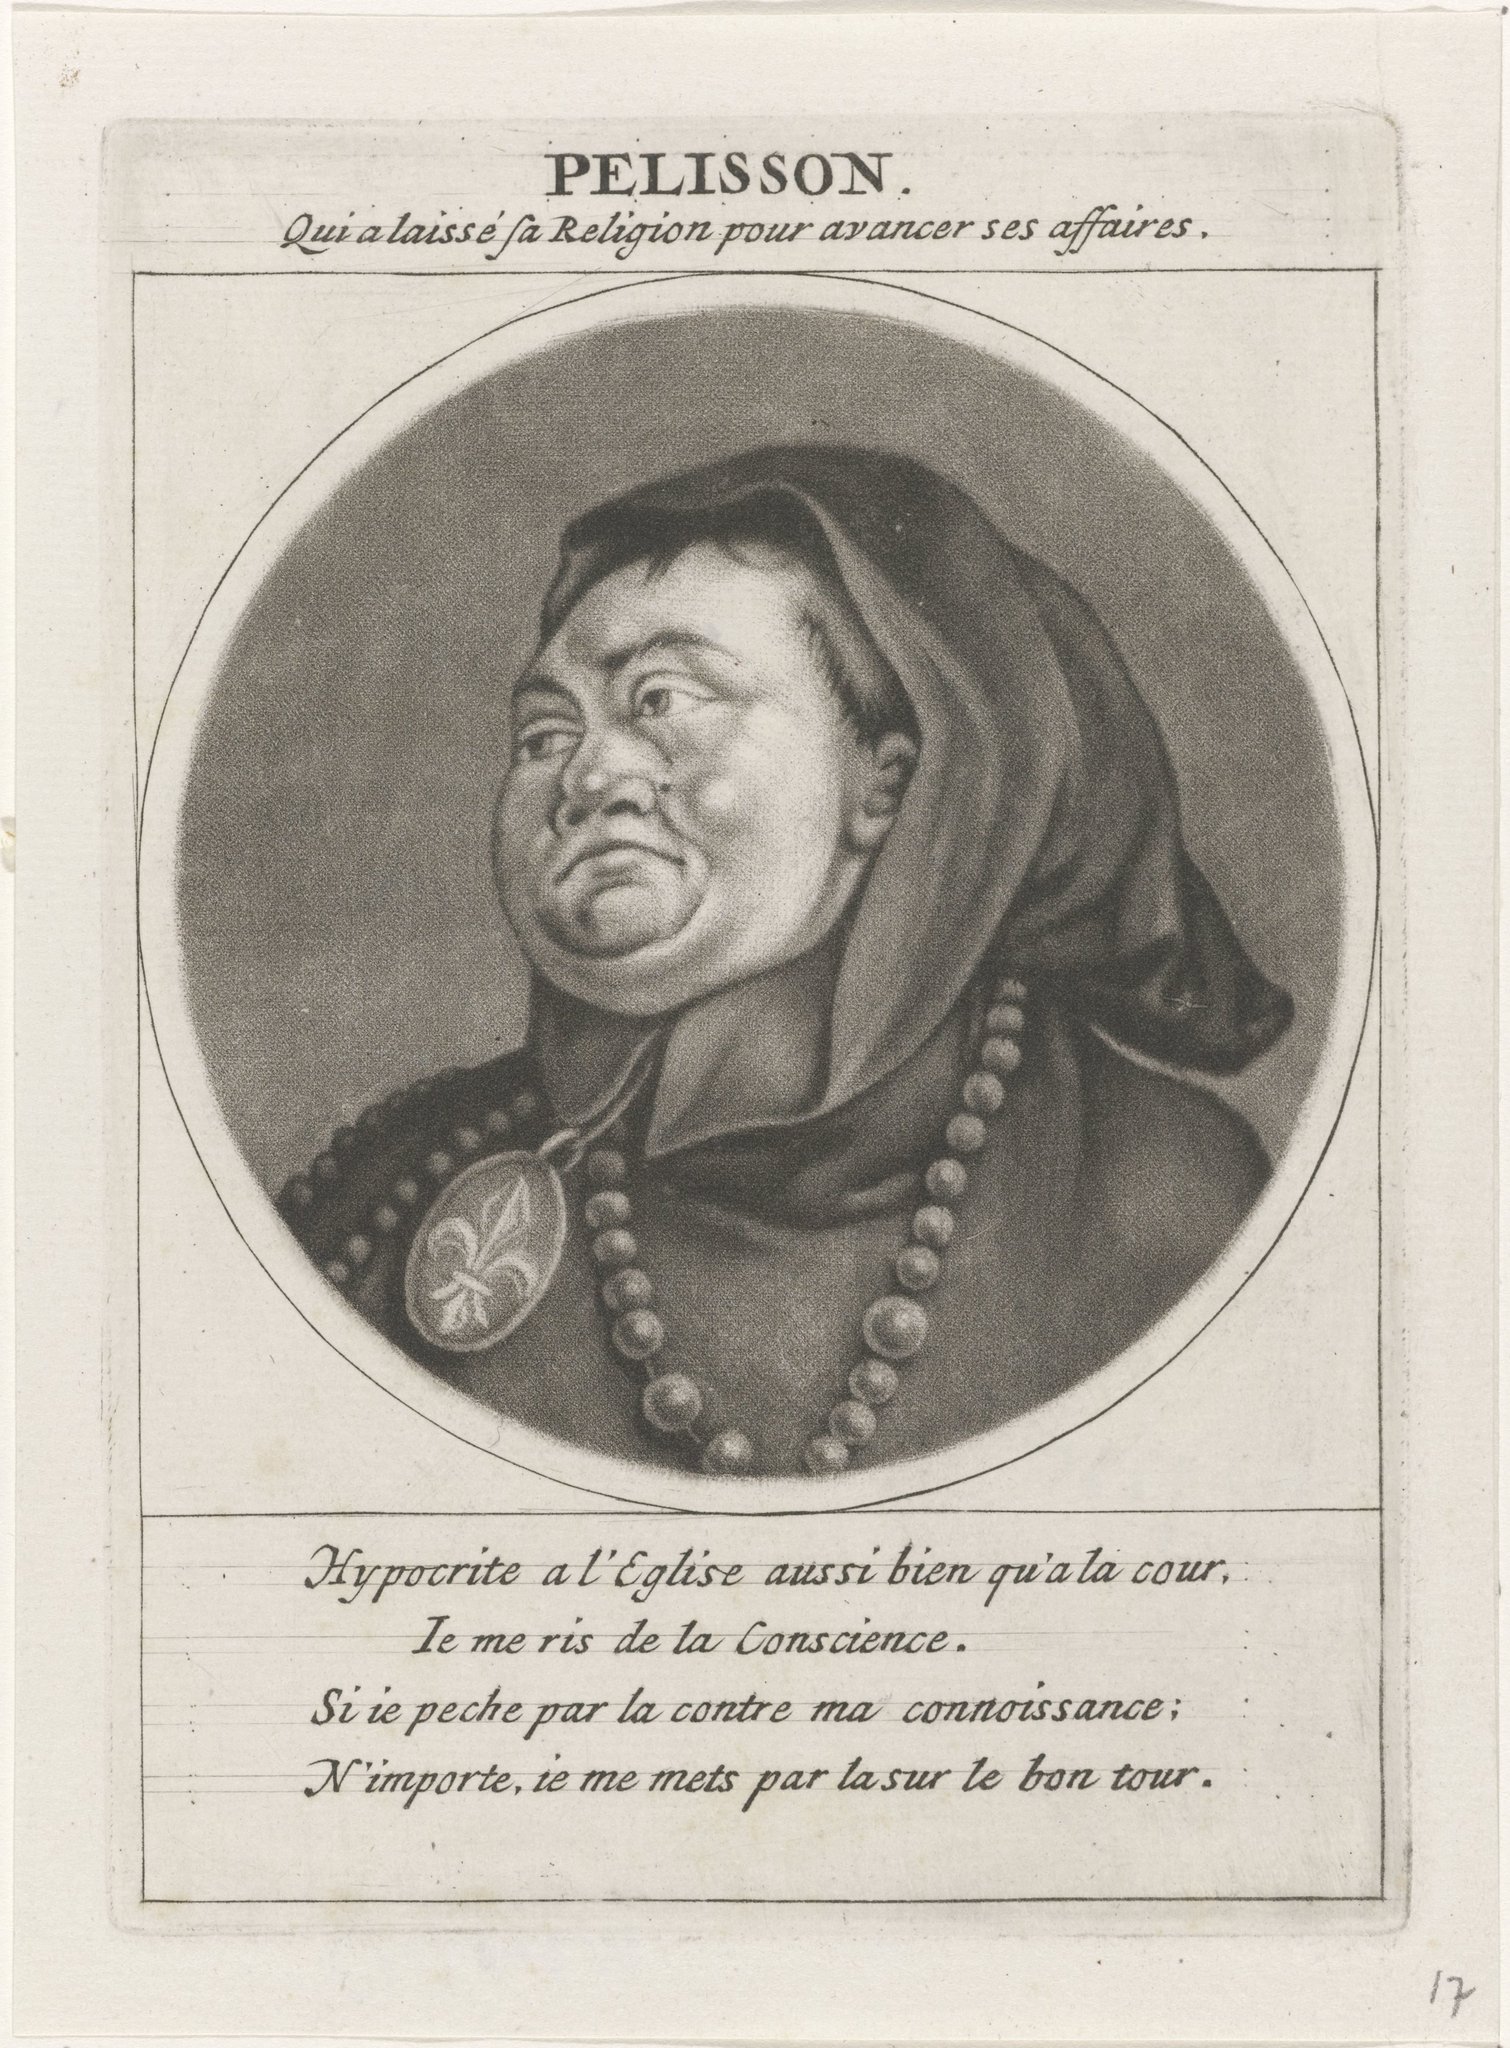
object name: print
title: Portret van Paul Pelisson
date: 1691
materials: paper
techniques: engraving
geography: paris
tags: fleur-de-lis ~ ornament, political caricatures and satires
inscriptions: collector's mark: Lugt 240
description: Titelpagina voor: Les Heros de la Ligue: ou la procession monacale, conduitte par Louis XIV, pour la conversion des Protestants de son royaume. Chez. Pere Peters en Louis le Grand: Parijs, 1691. (De uitgevers zijn fictief.)